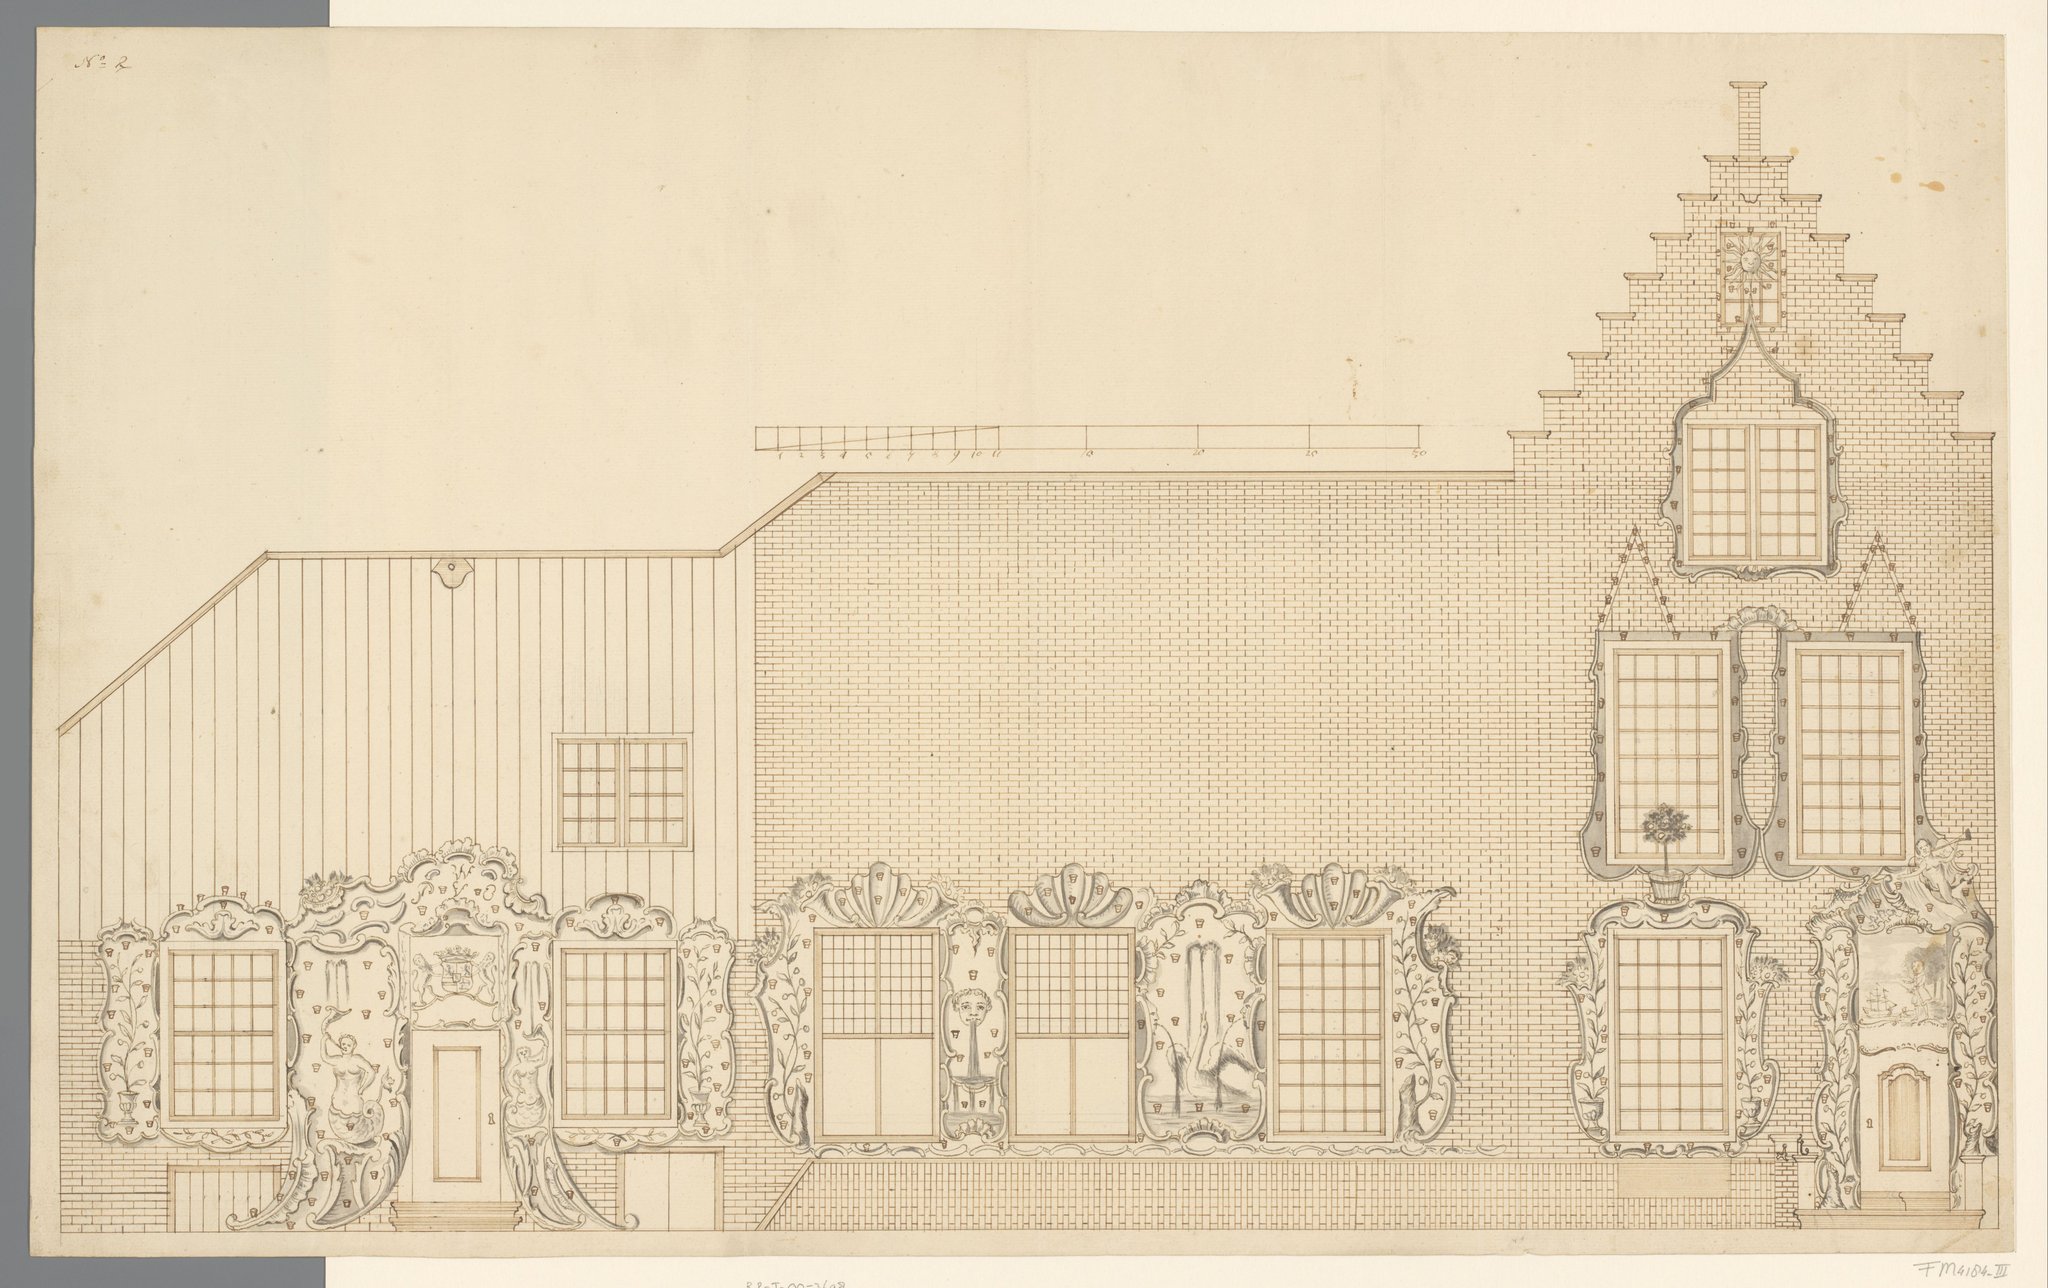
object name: drawing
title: Illuminatie van een huis te Vlissingen, 1766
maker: Anonymous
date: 1766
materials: paper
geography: northern netherlands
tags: william v (prince of orange), bonfire, fire-works (+ illumination, fire-works ~ festive activities), flushing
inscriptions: collector's mark: Lugt 2228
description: Illuminatie van een groot huis met lage bijgebouwen te Vlissingen ter gelegenheid van de inhuldiging van stadhouder Willem V op 30 mei 1766. Gemerkt linksboven: No. 2.